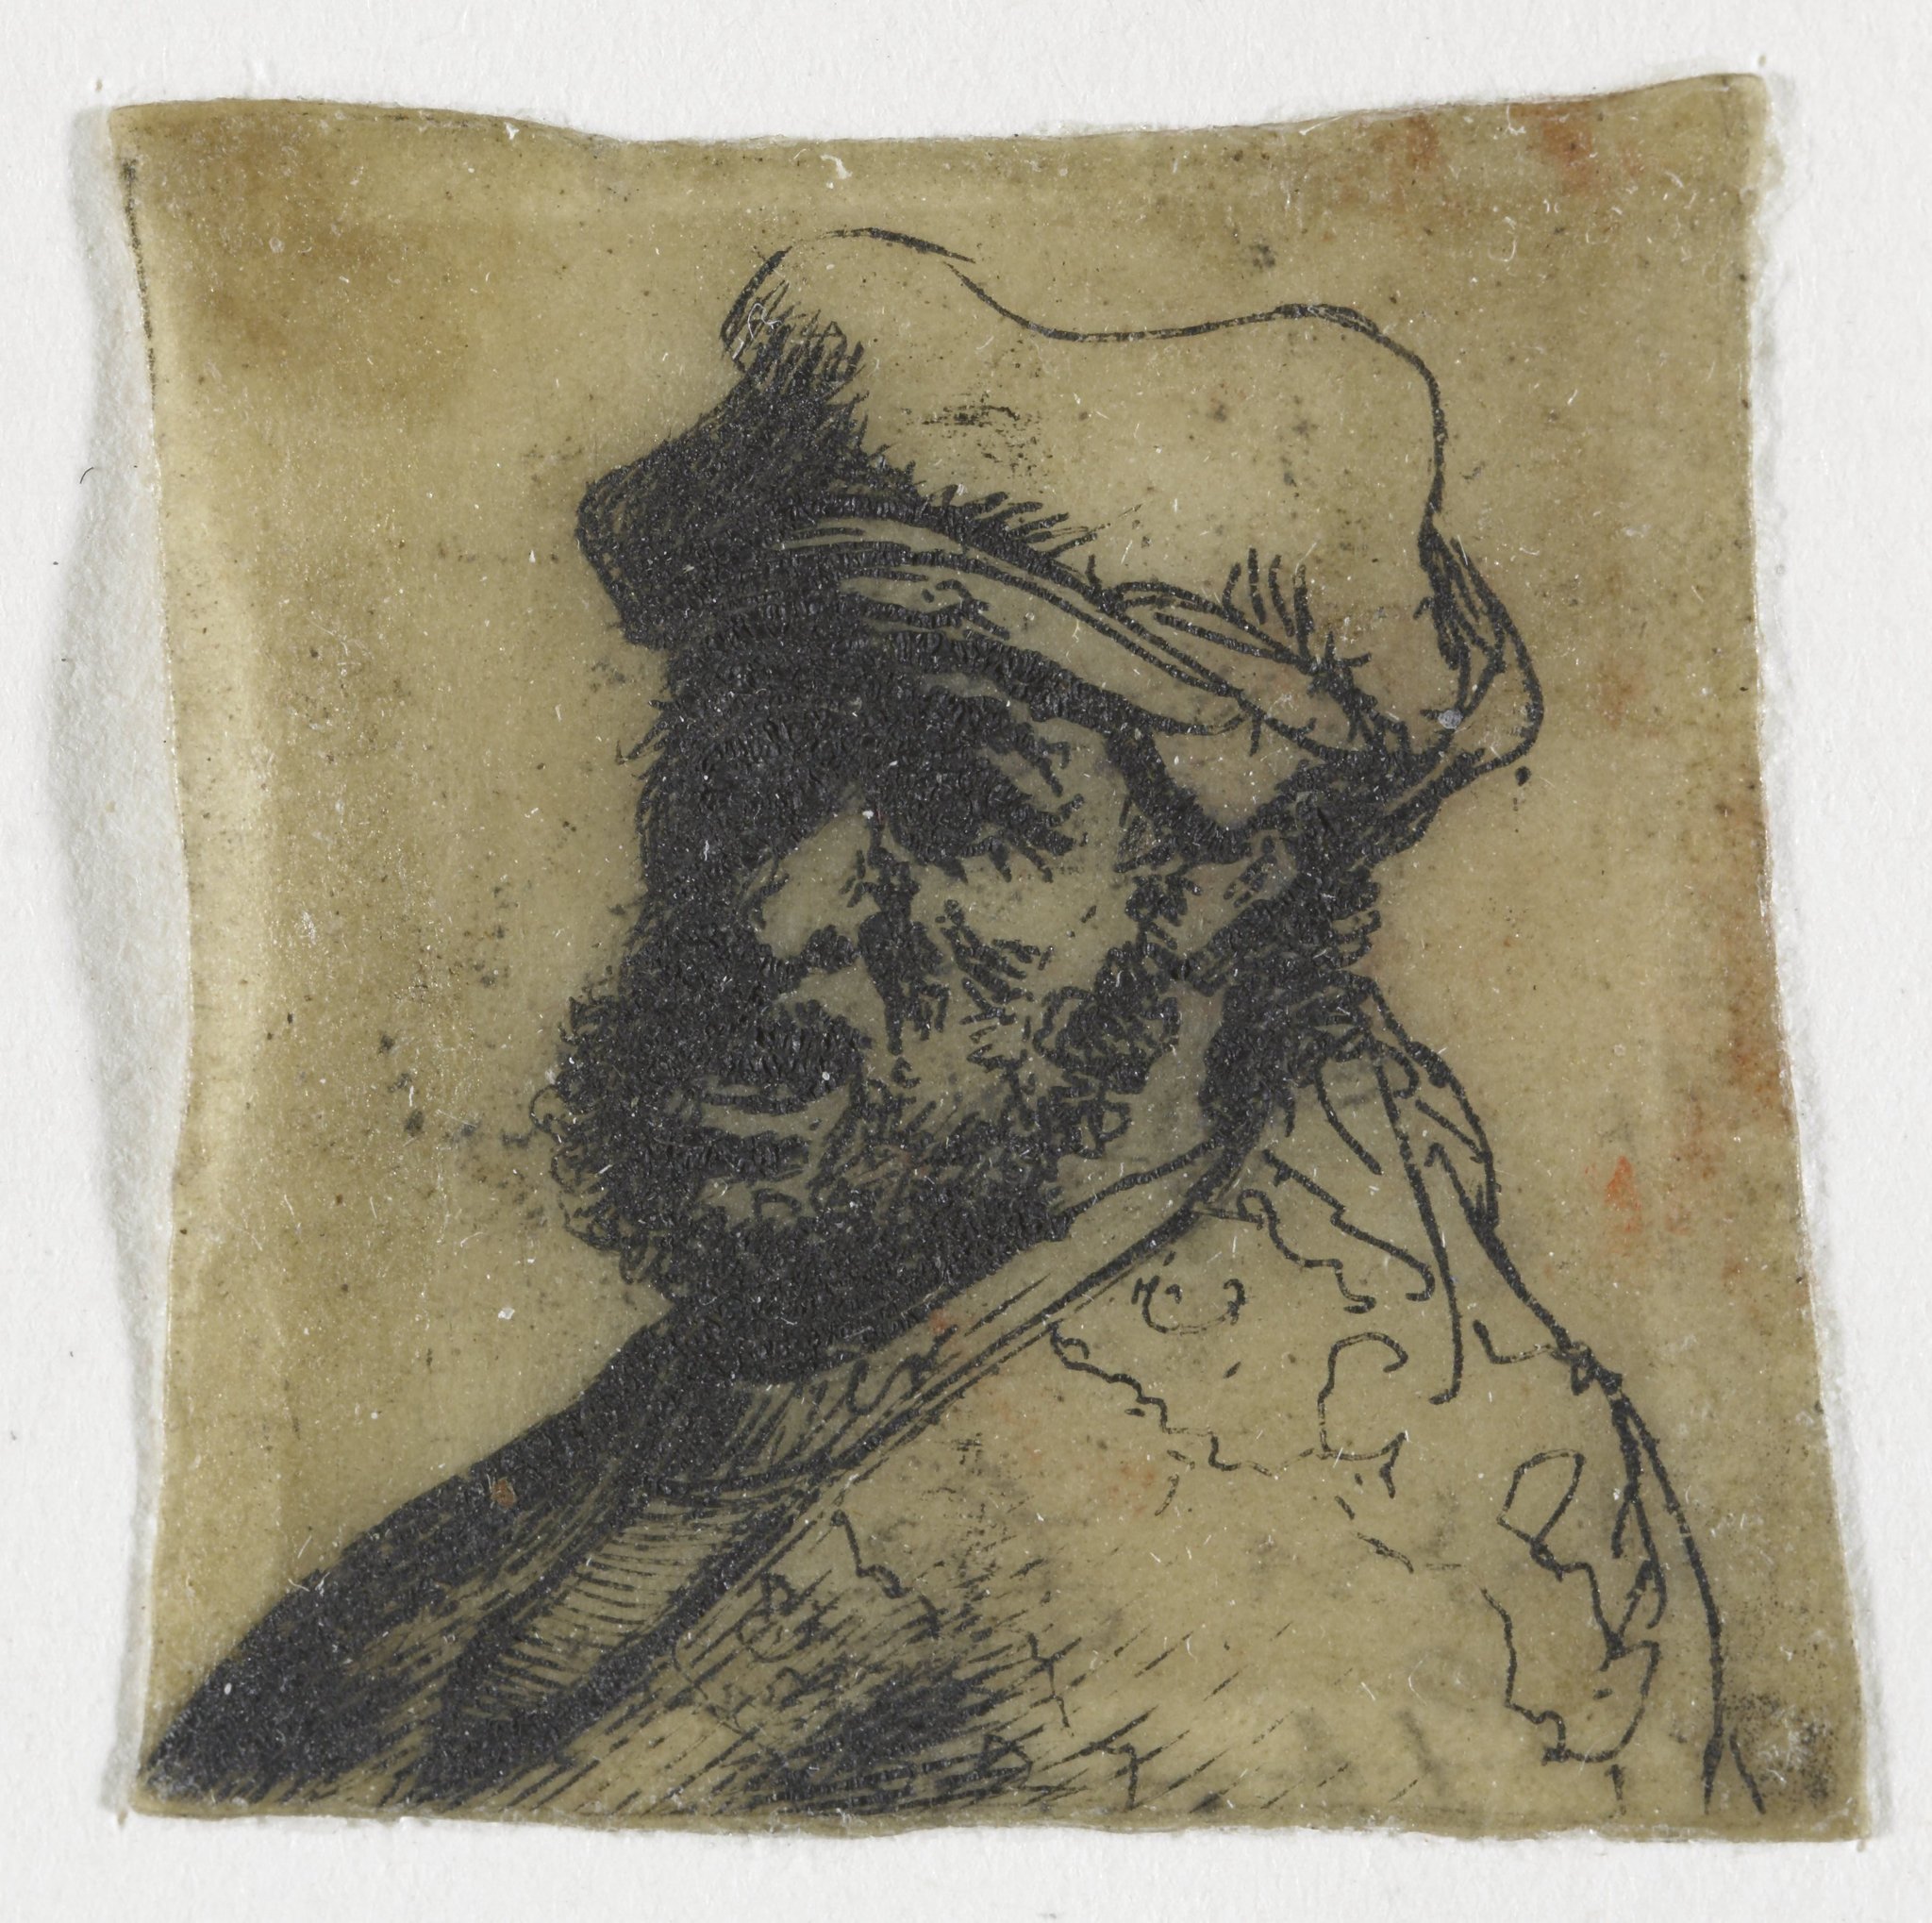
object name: print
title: Sheet of studies of men's heads: man crying out, three quarters left: bust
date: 1629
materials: parchment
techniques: etching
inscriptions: collector's mark: Lugt 240